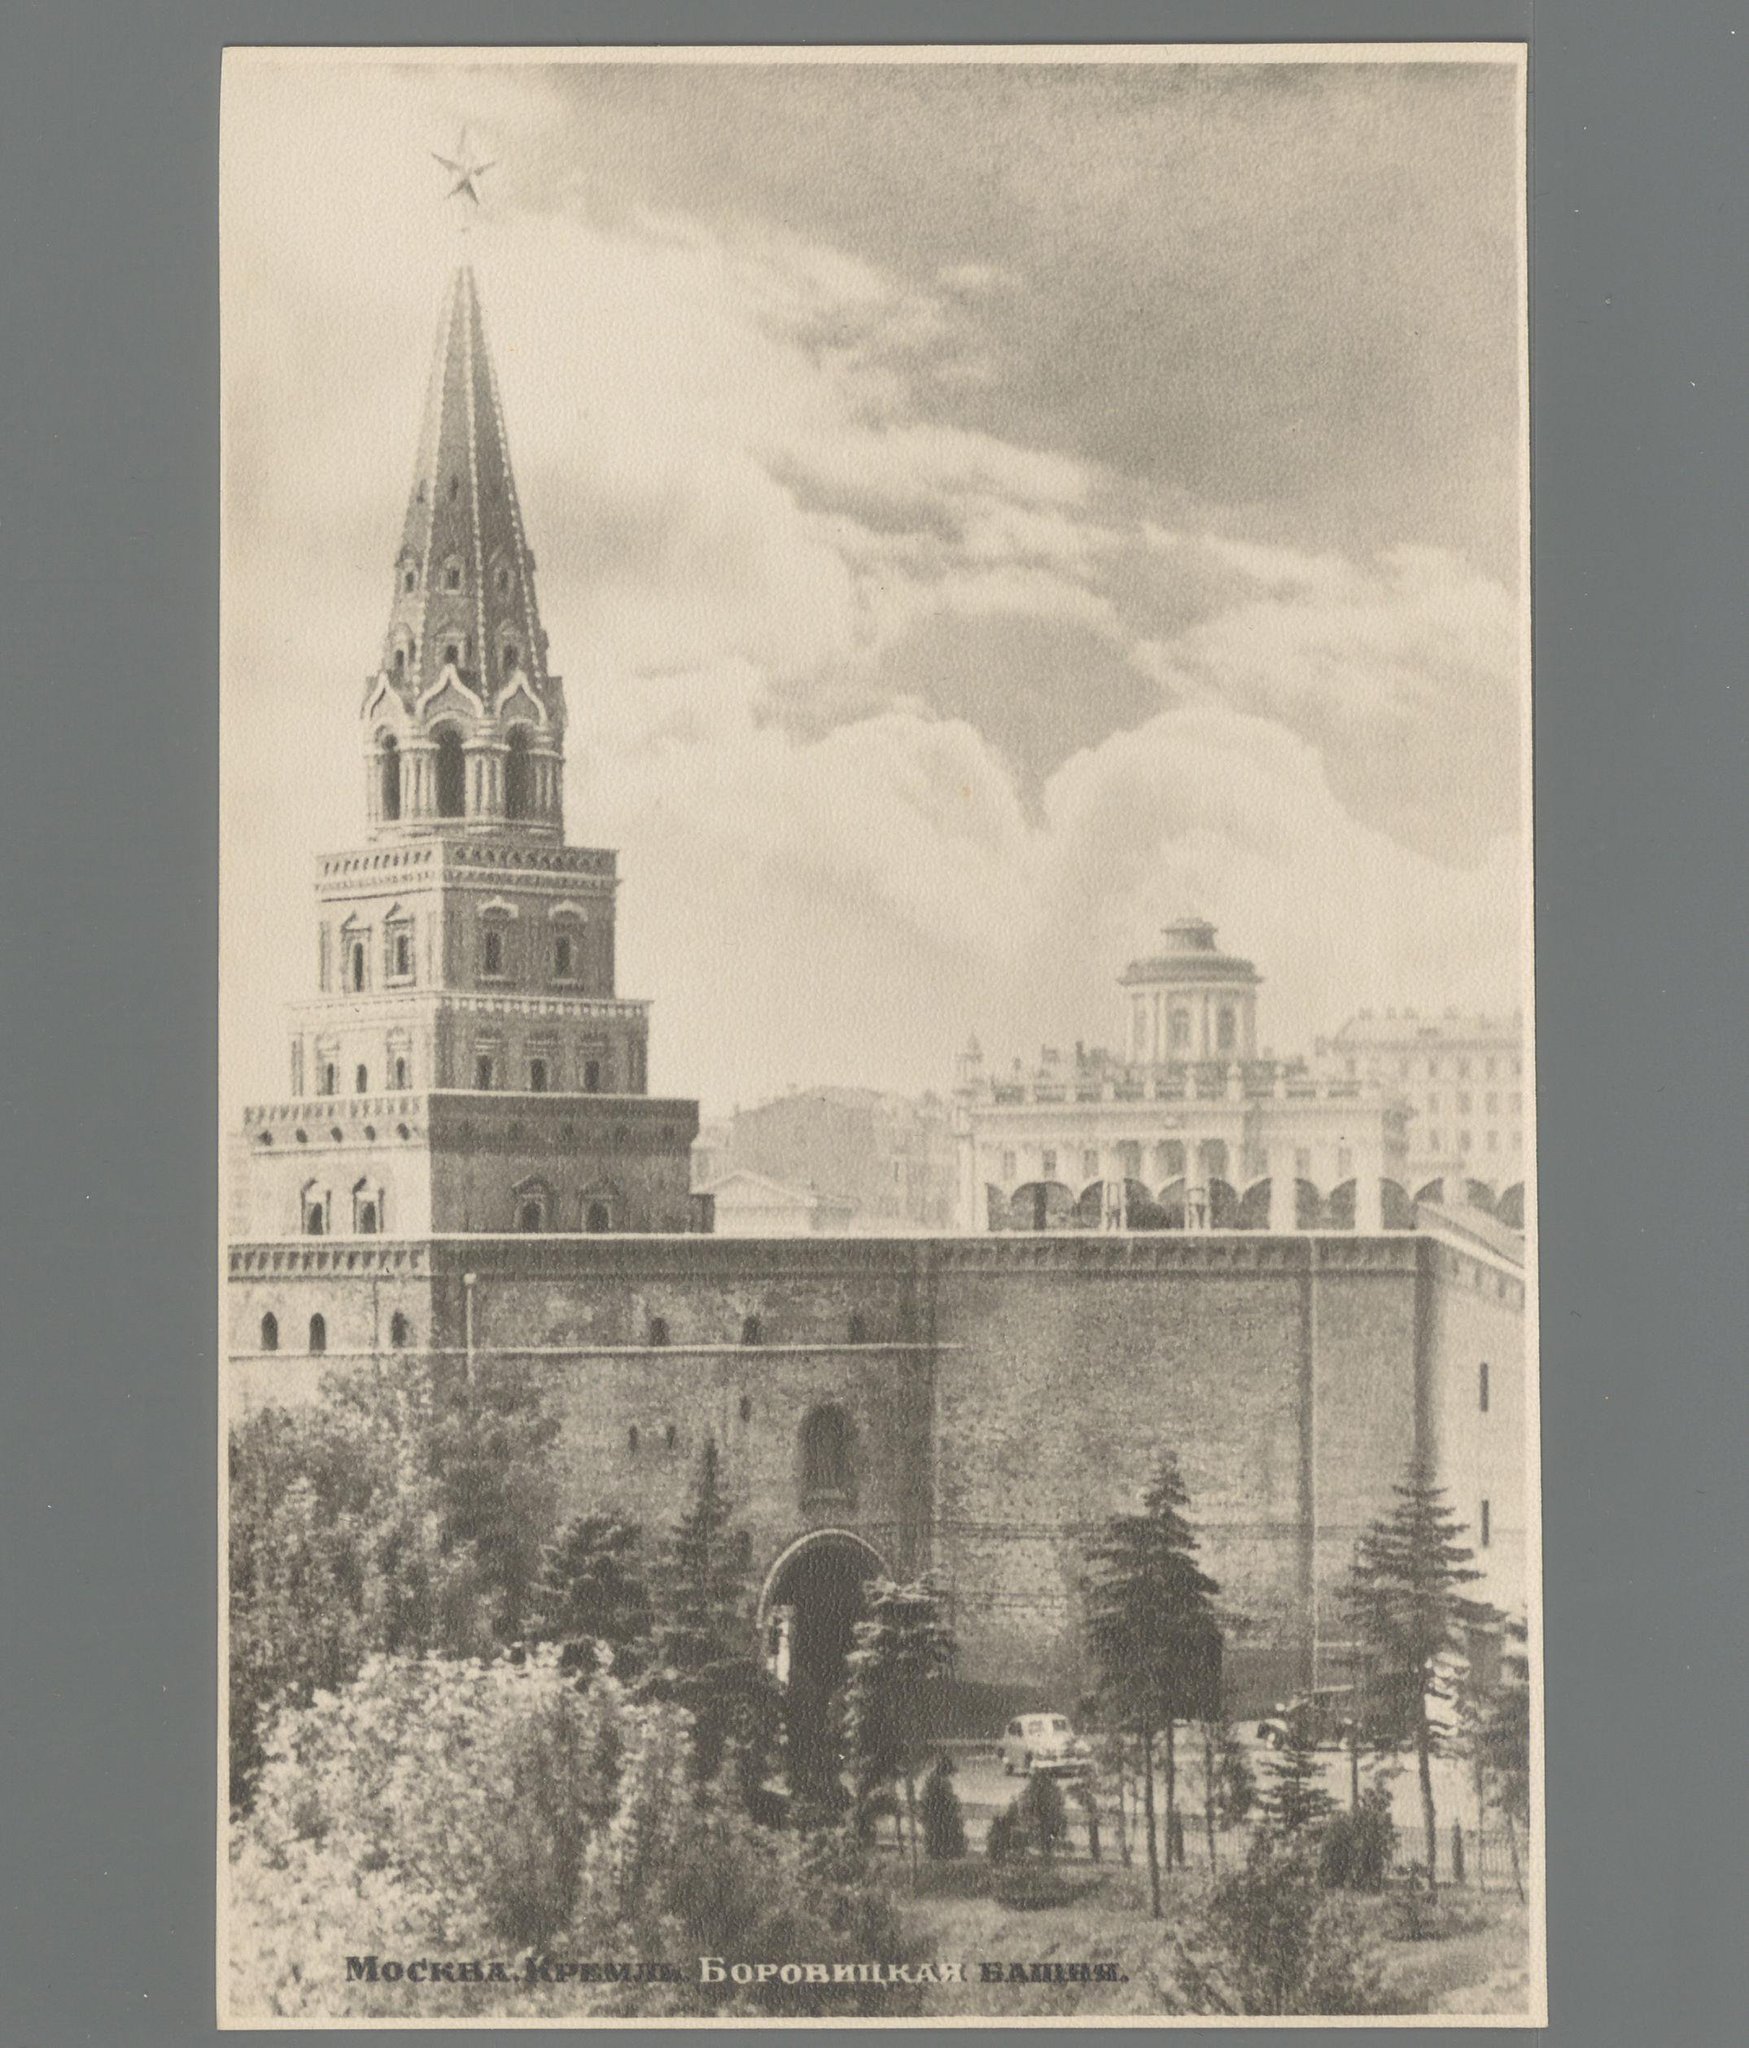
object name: photograph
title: Gezicht op de Borovitskajatoren in het Kremlin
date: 1954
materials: paper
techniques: gelatin silver print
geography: moscow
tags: towers ~ fortified city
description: De titel op object staat in het Russisch.